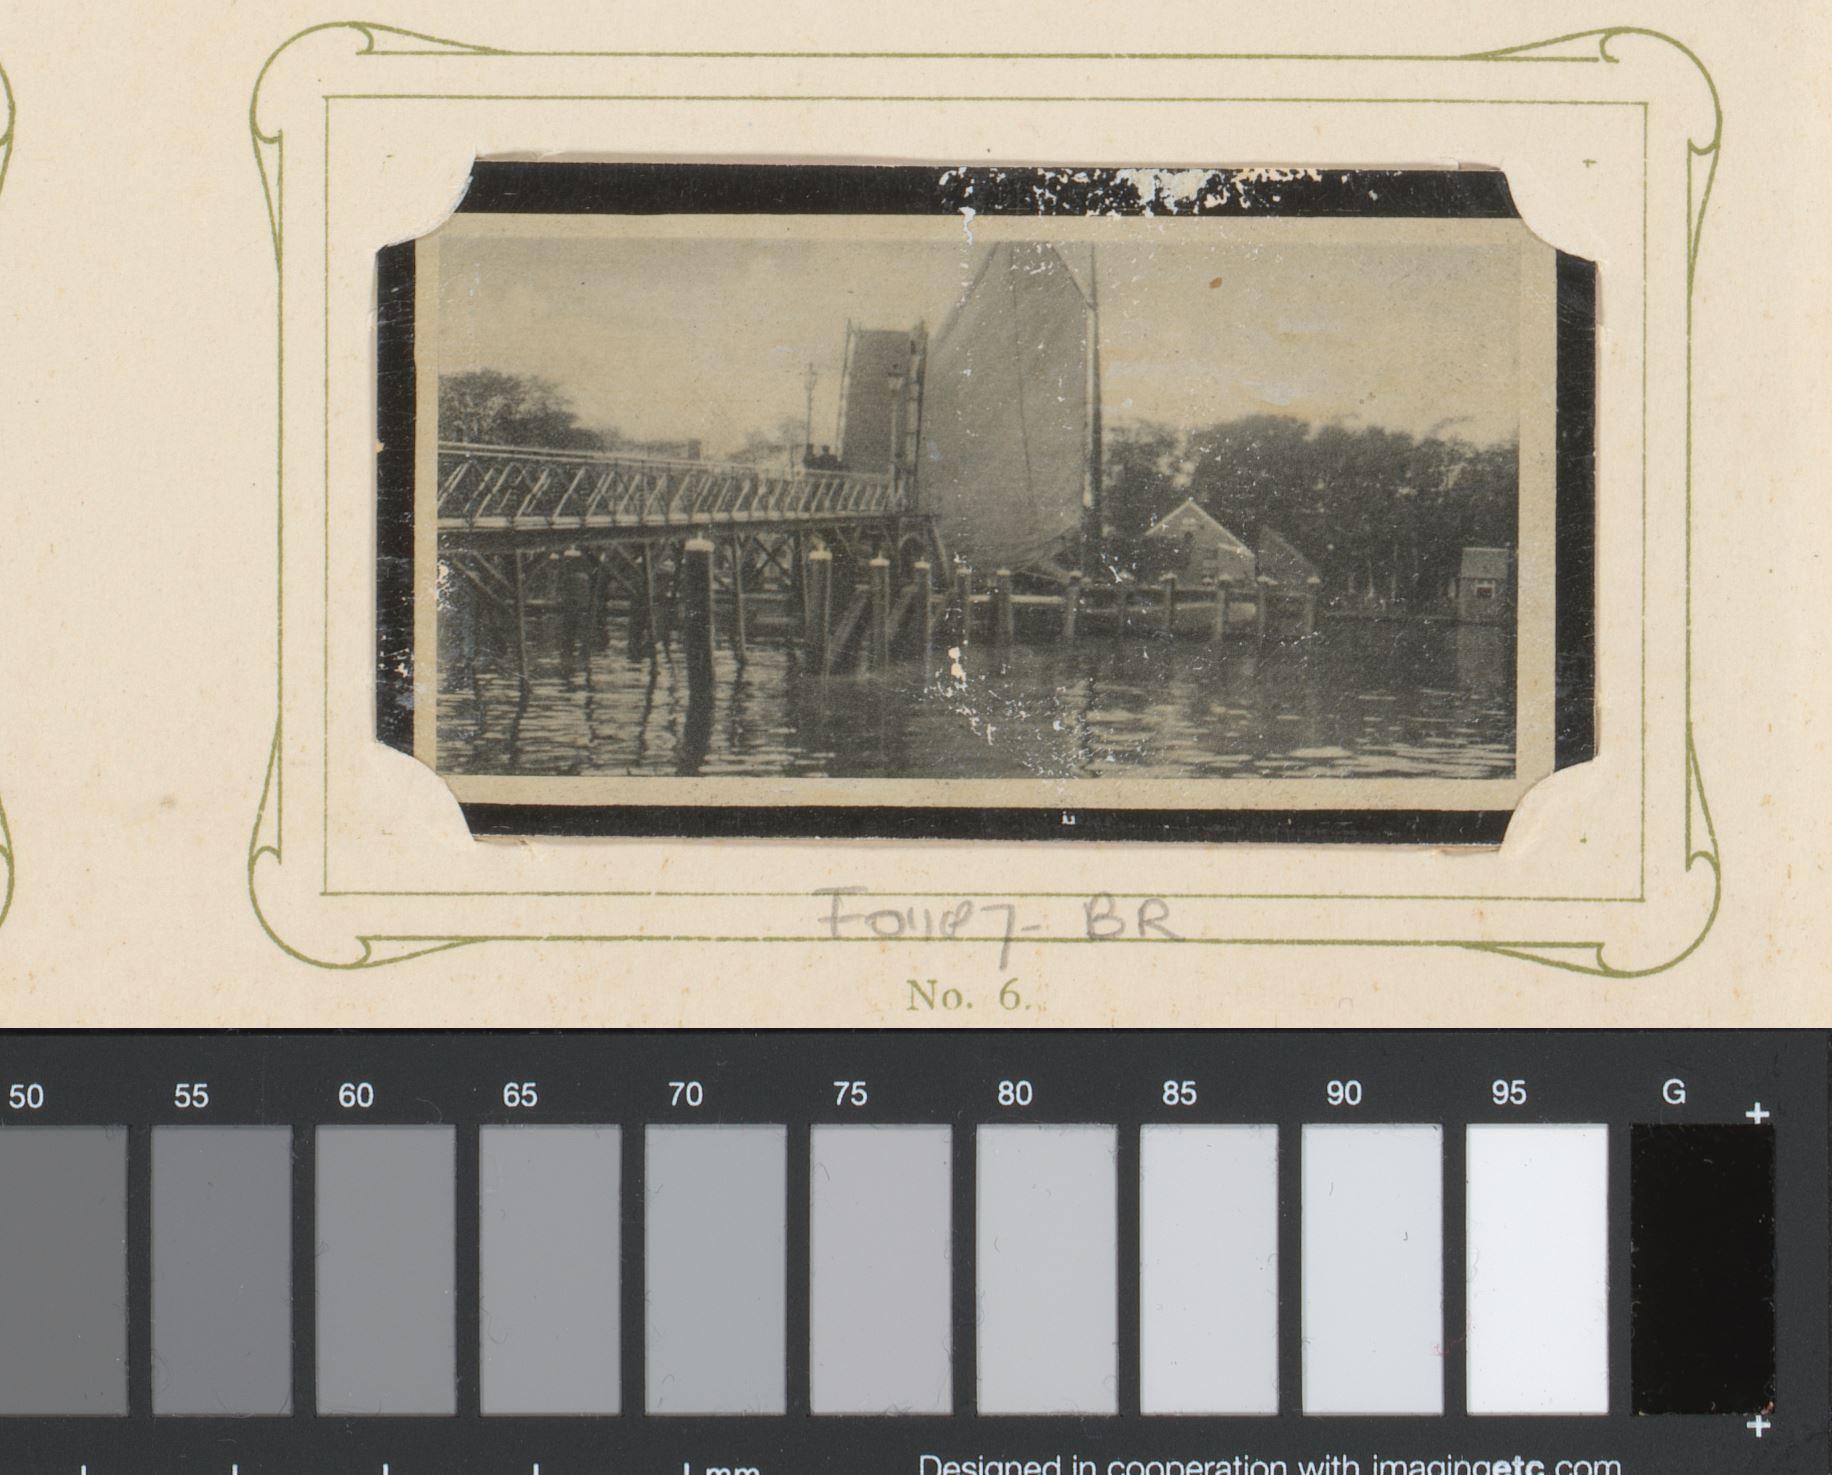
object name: photomechanical print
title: Gezicht op een basculebrug in Zaandam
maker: Anonymous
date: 1905-1906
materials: paper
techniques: photograph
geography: zaandam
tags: bascule bridge, canals, waters (in city)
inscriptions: inscription: ‘No. 6./ Basculebrug over de Zaan.’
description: Deze prent maakt deel uit van een album.